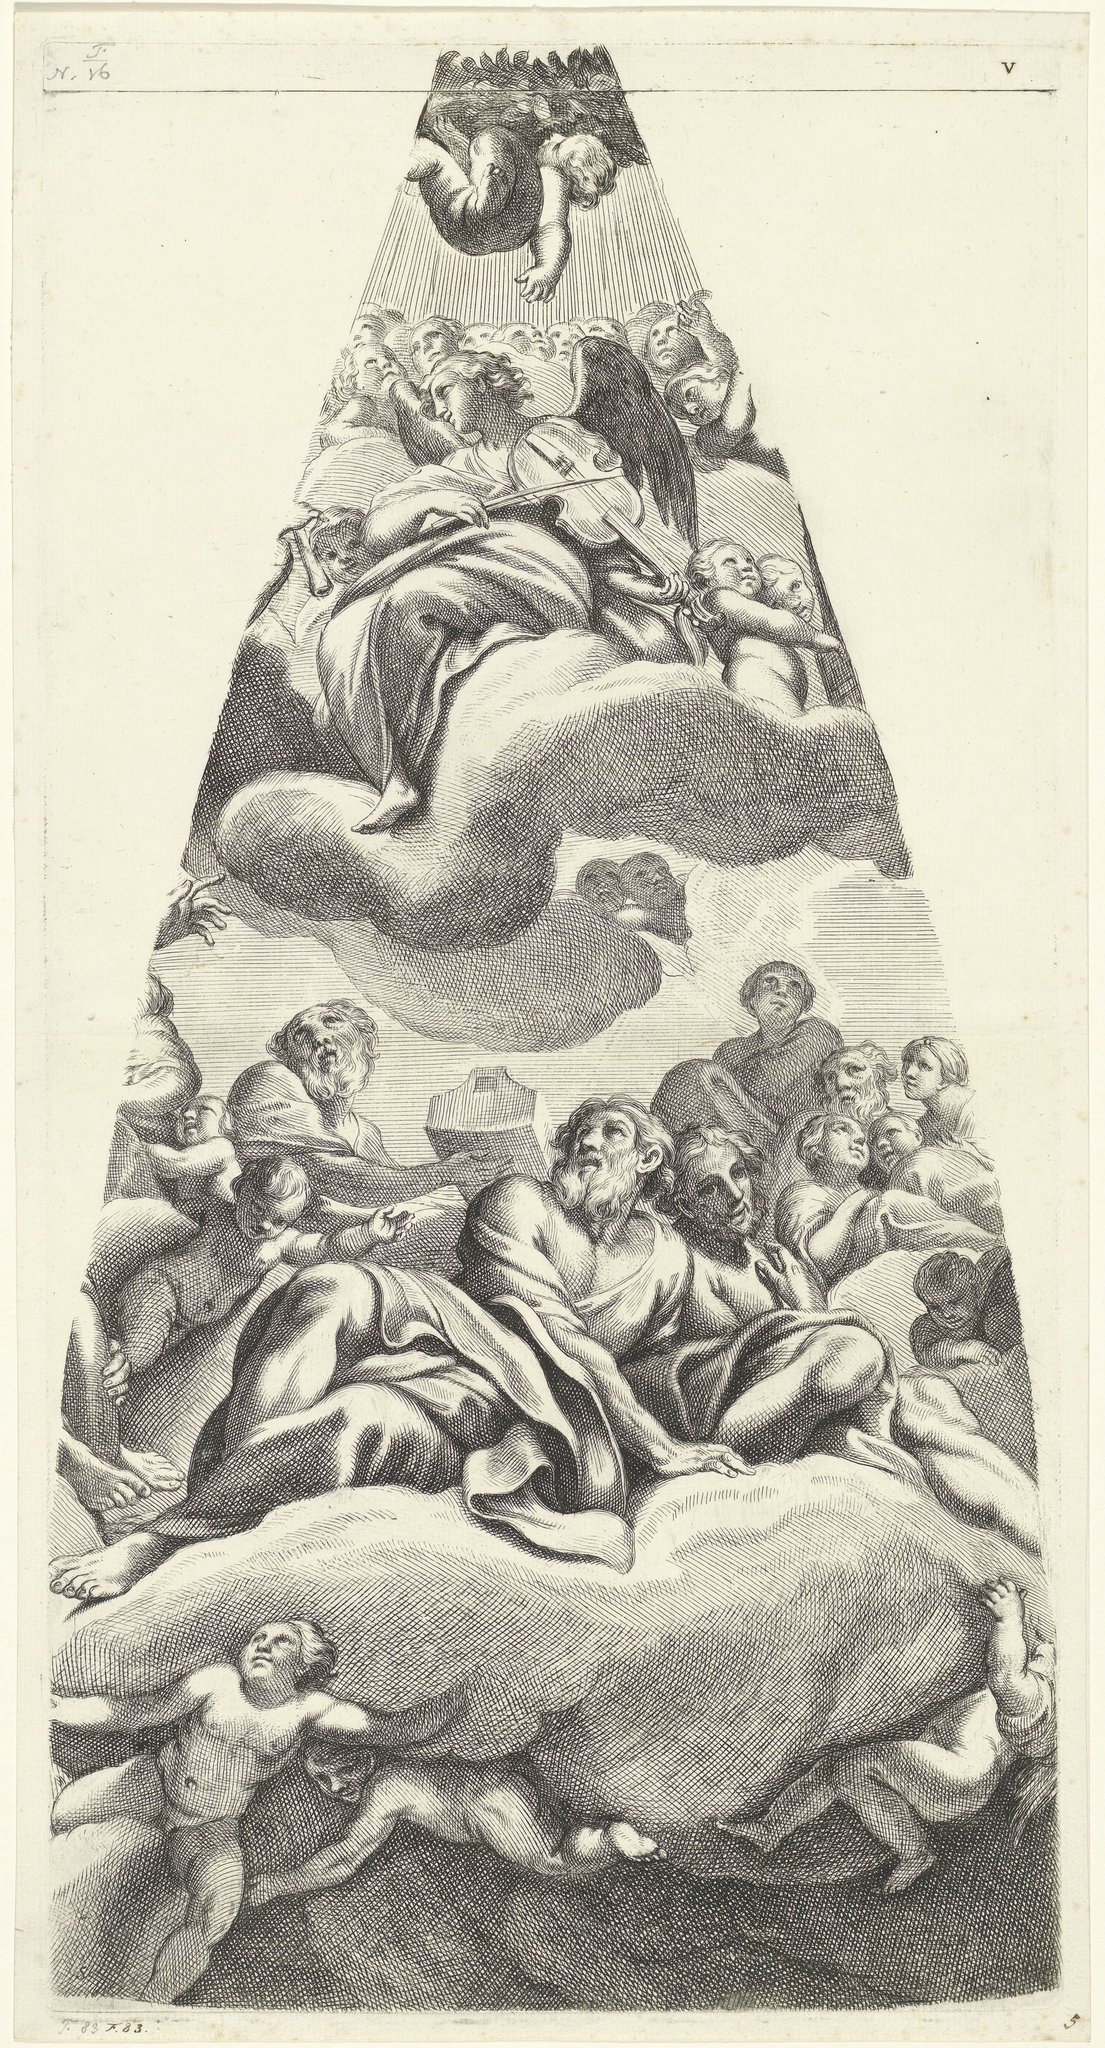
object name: print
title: Hemelvaart van Maria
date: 1680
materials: paper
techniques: engraving, etching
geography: rome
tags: angels singing, making music, story of noah, groups of persons from the old testament, angels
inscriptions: collector's mark: Lugt 11, collector's mark: Lugt 10, collector's mark: ‘Hinloopen’, number: ‘5’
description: Prent uit een reeks van 8 prenten naar de fresco's door Giovanni Lanfranco in de koepel van de San Andrea della Valle te Rome.